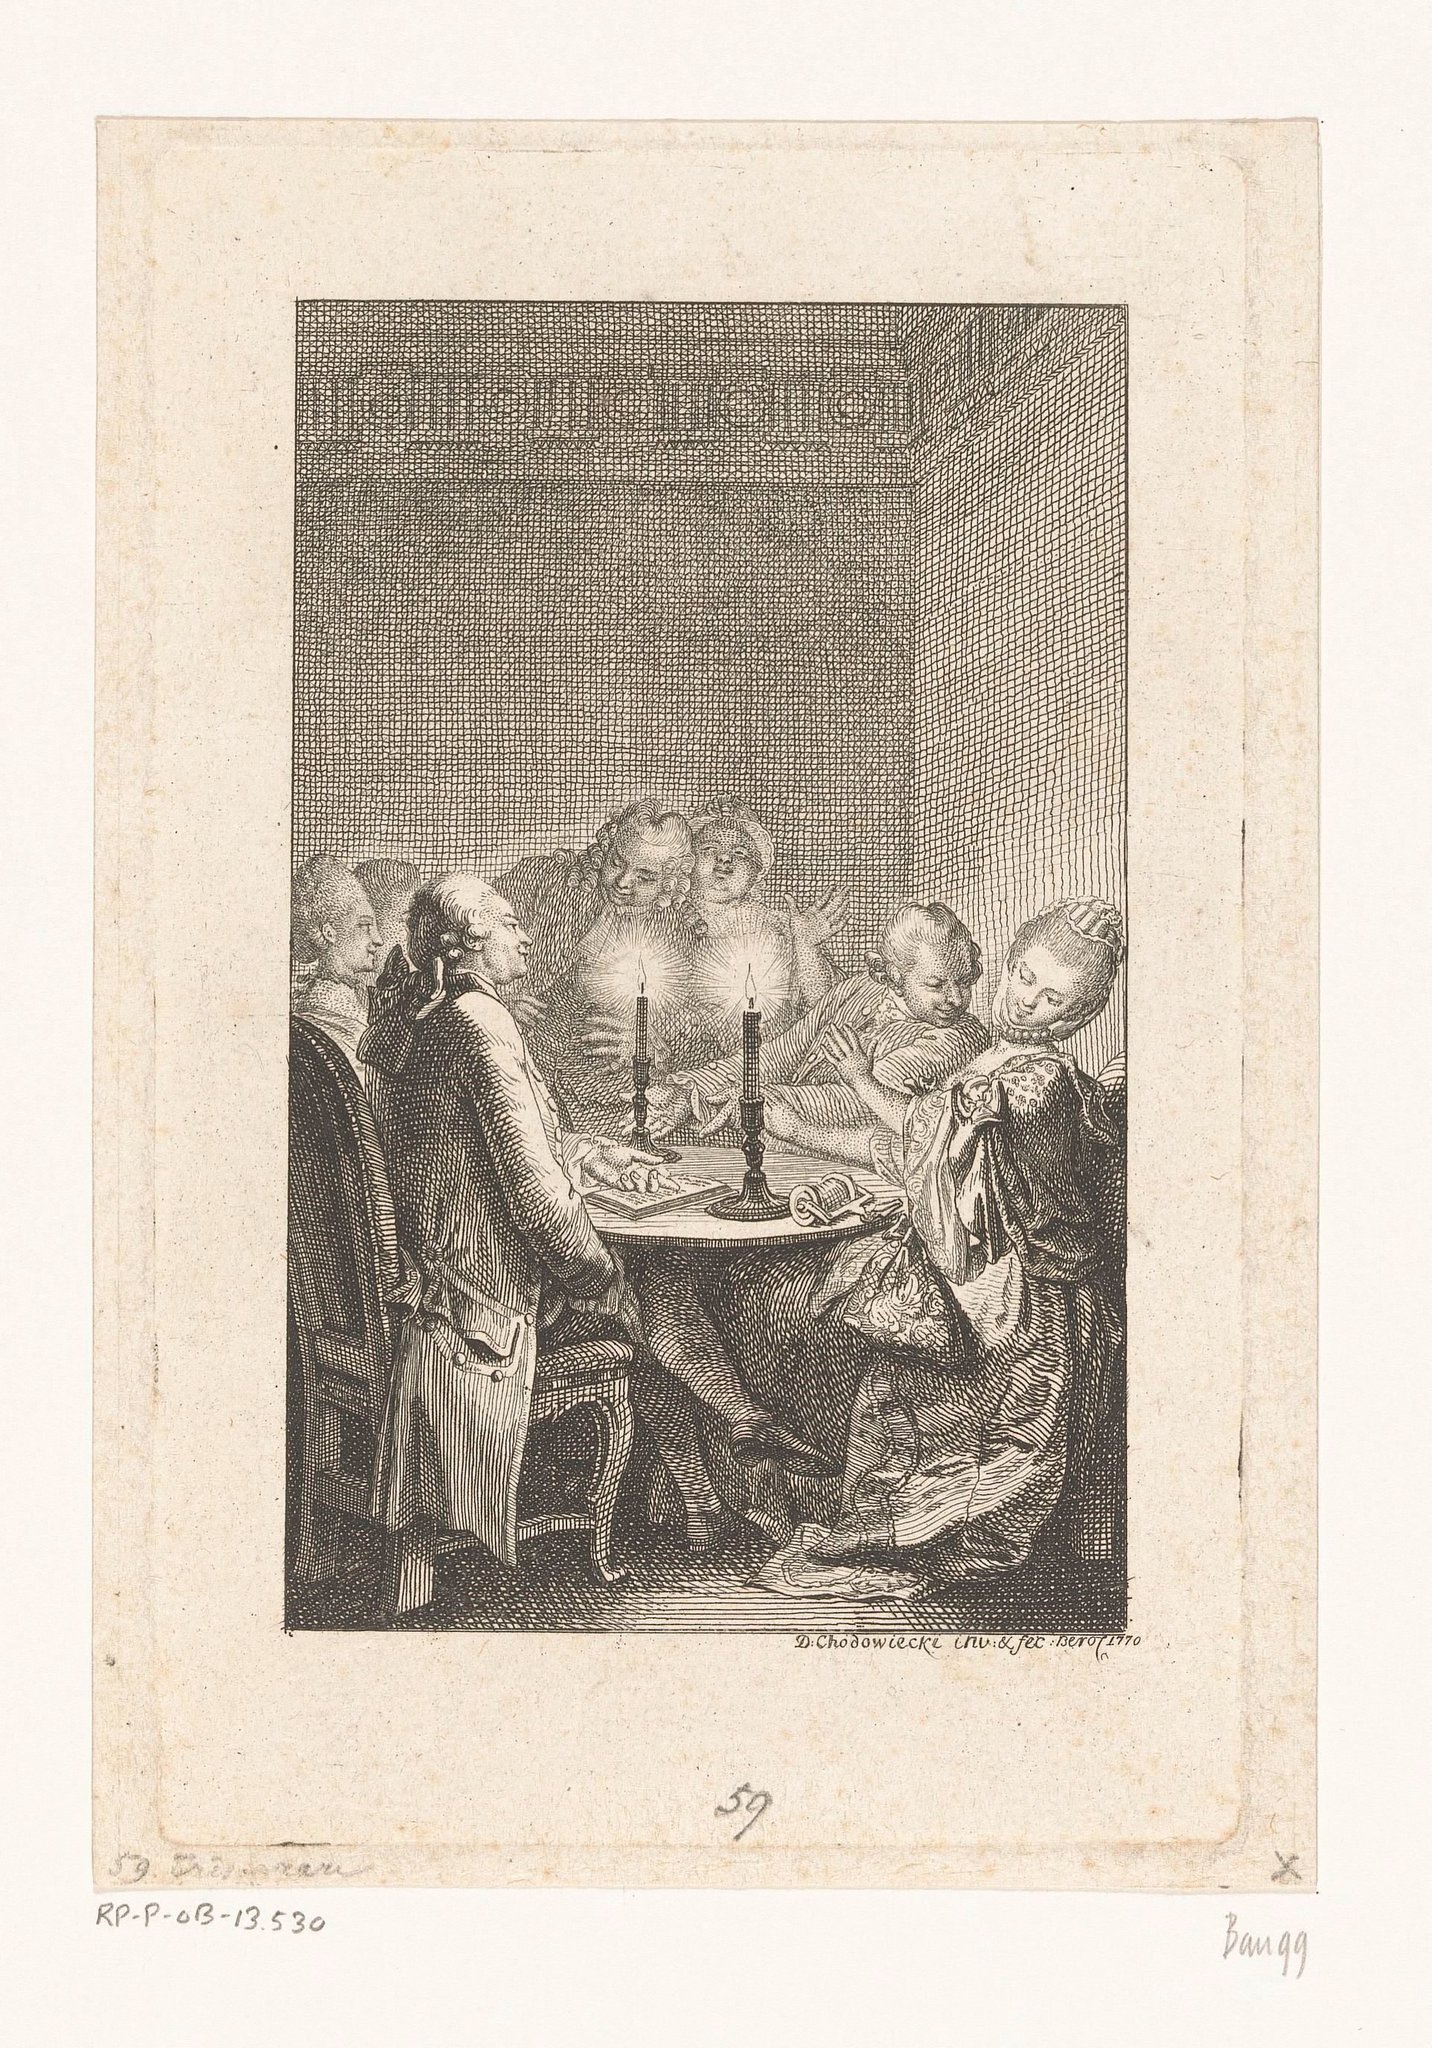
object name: print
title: Mannen en vrouwen rond een tafel met kaarsen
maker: daniel nikolaus chodowiecki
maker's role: draughtsman, print maker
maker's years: 1726-1801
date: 1770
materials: paper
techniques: etching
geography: berlin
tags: visiting; receiving guests; elegant company, candle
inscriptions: inscription: ‘c 1,30’, collector's mark: Lugt 2228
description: Prent ook gebruikt in: Vade Mecum für lustige Leute (...). Dl. 5. Berlijn: August Mylius, 1783.